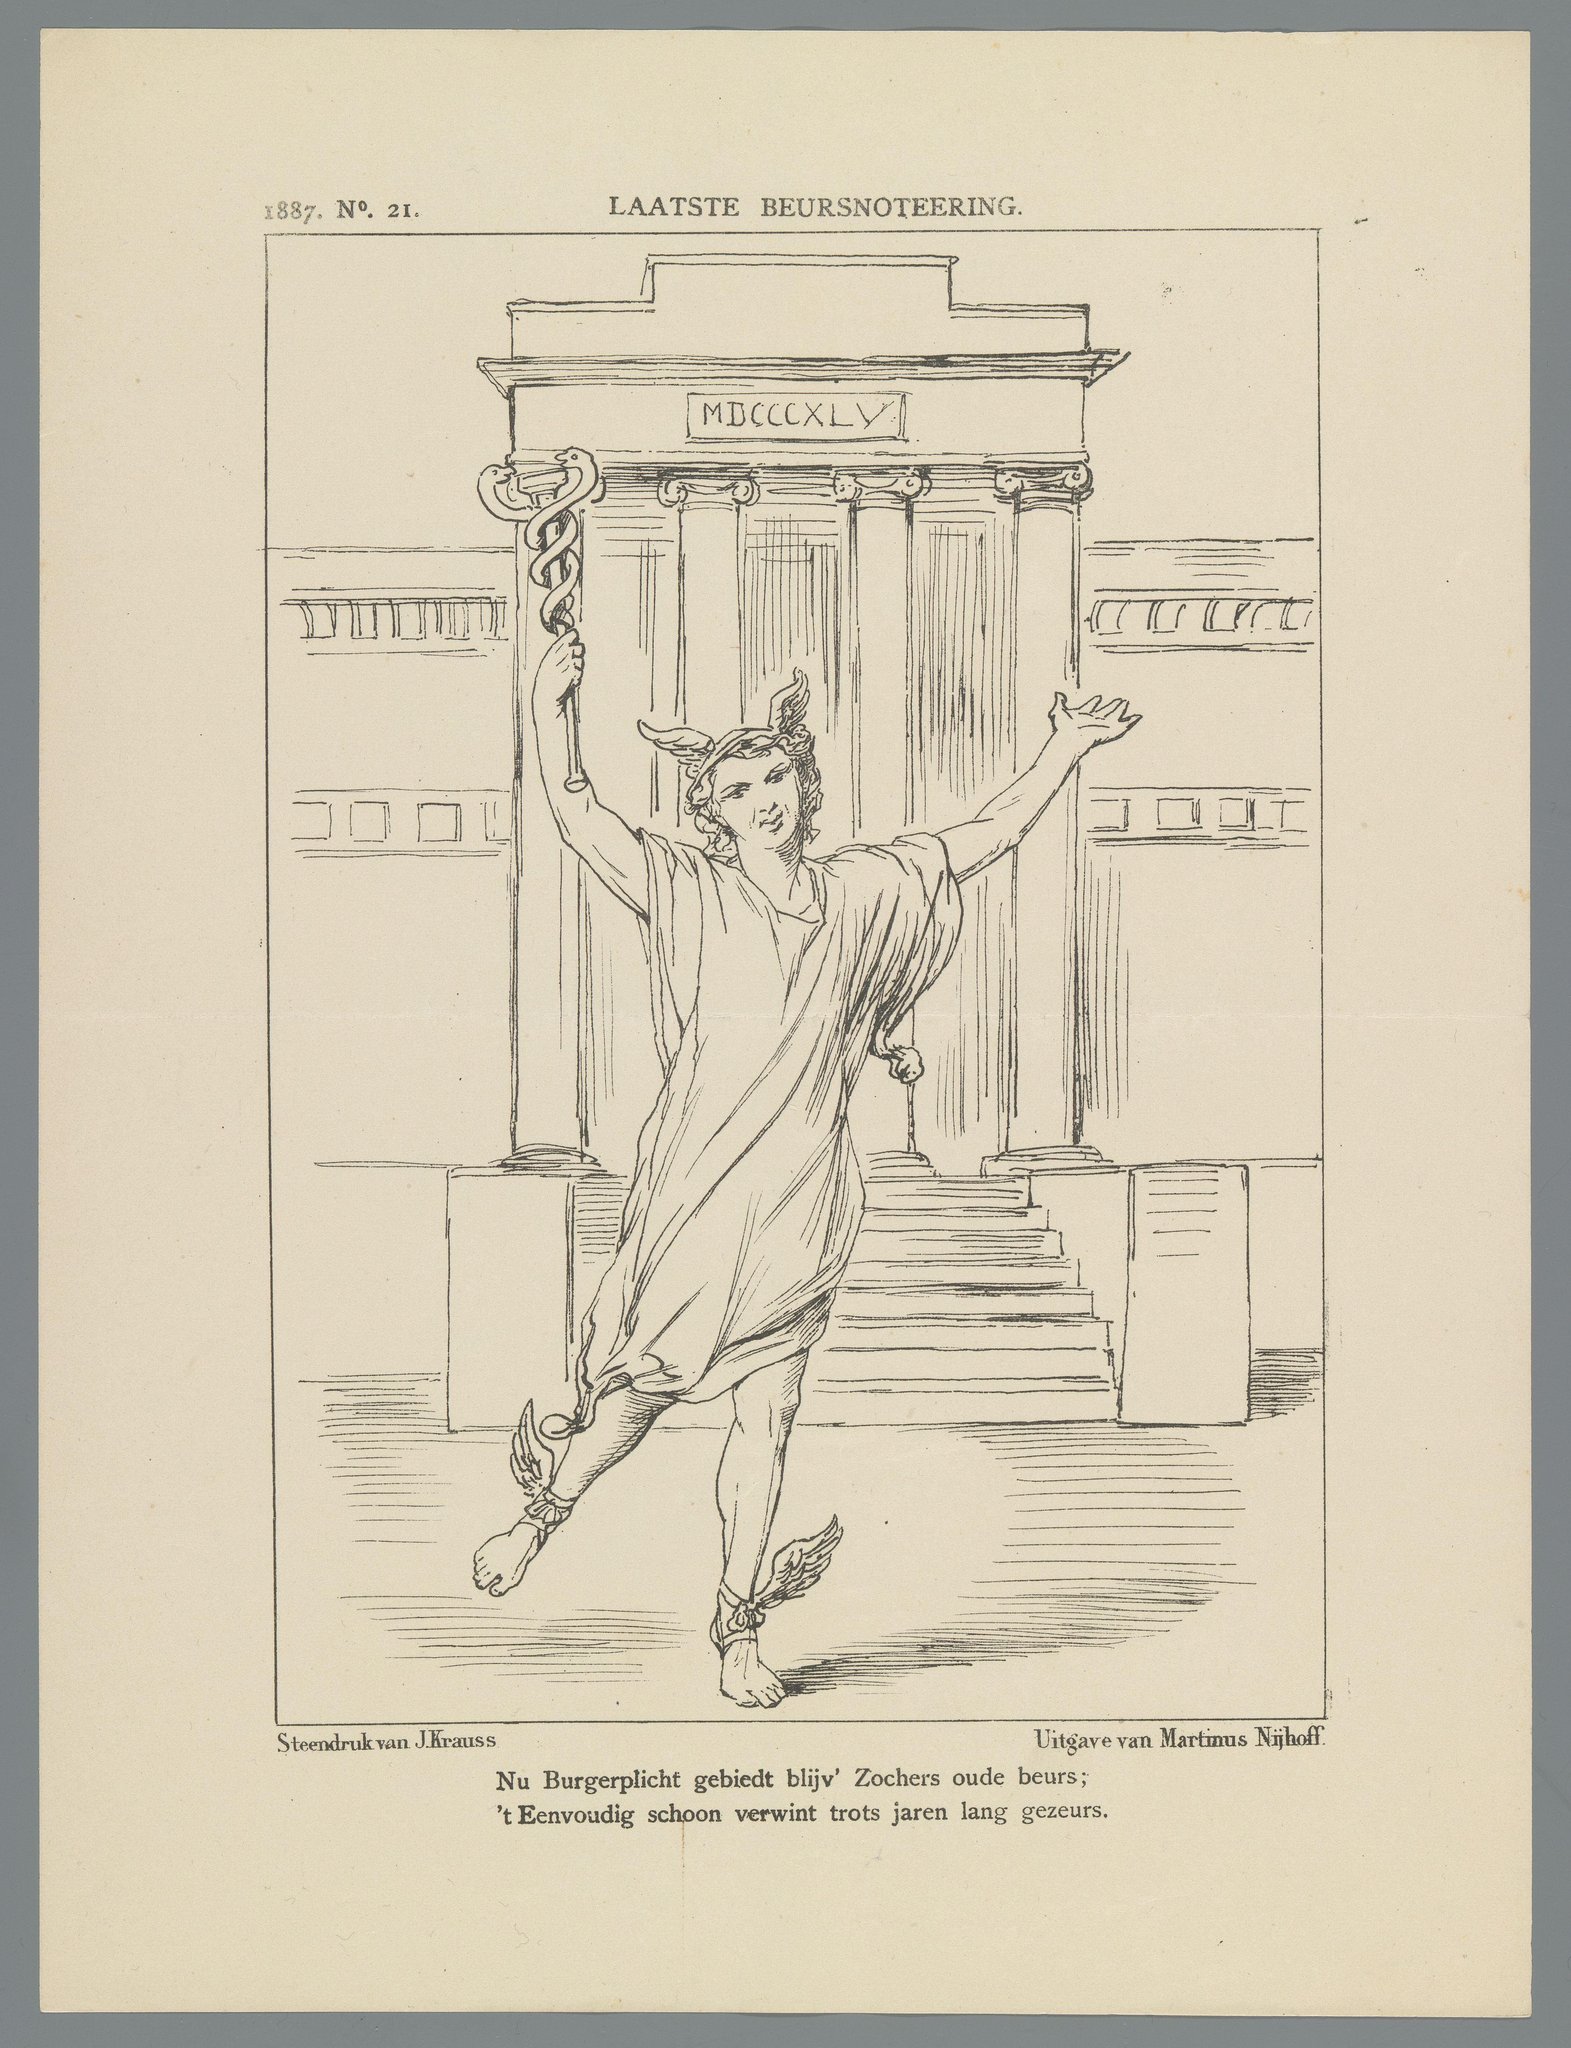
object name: print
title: Spotprent bij de sluiting van de beurs van Zocher, 1887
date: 1887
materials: paper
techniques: lithograph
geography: netherlands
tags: beurs van zocher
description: Spotprent bij de sluiting van de oude beurs van Zocher te Amsterdam. Plaat verschenen bij het weekblad De Nederlandsche Spectator, nr. 21, 1887.